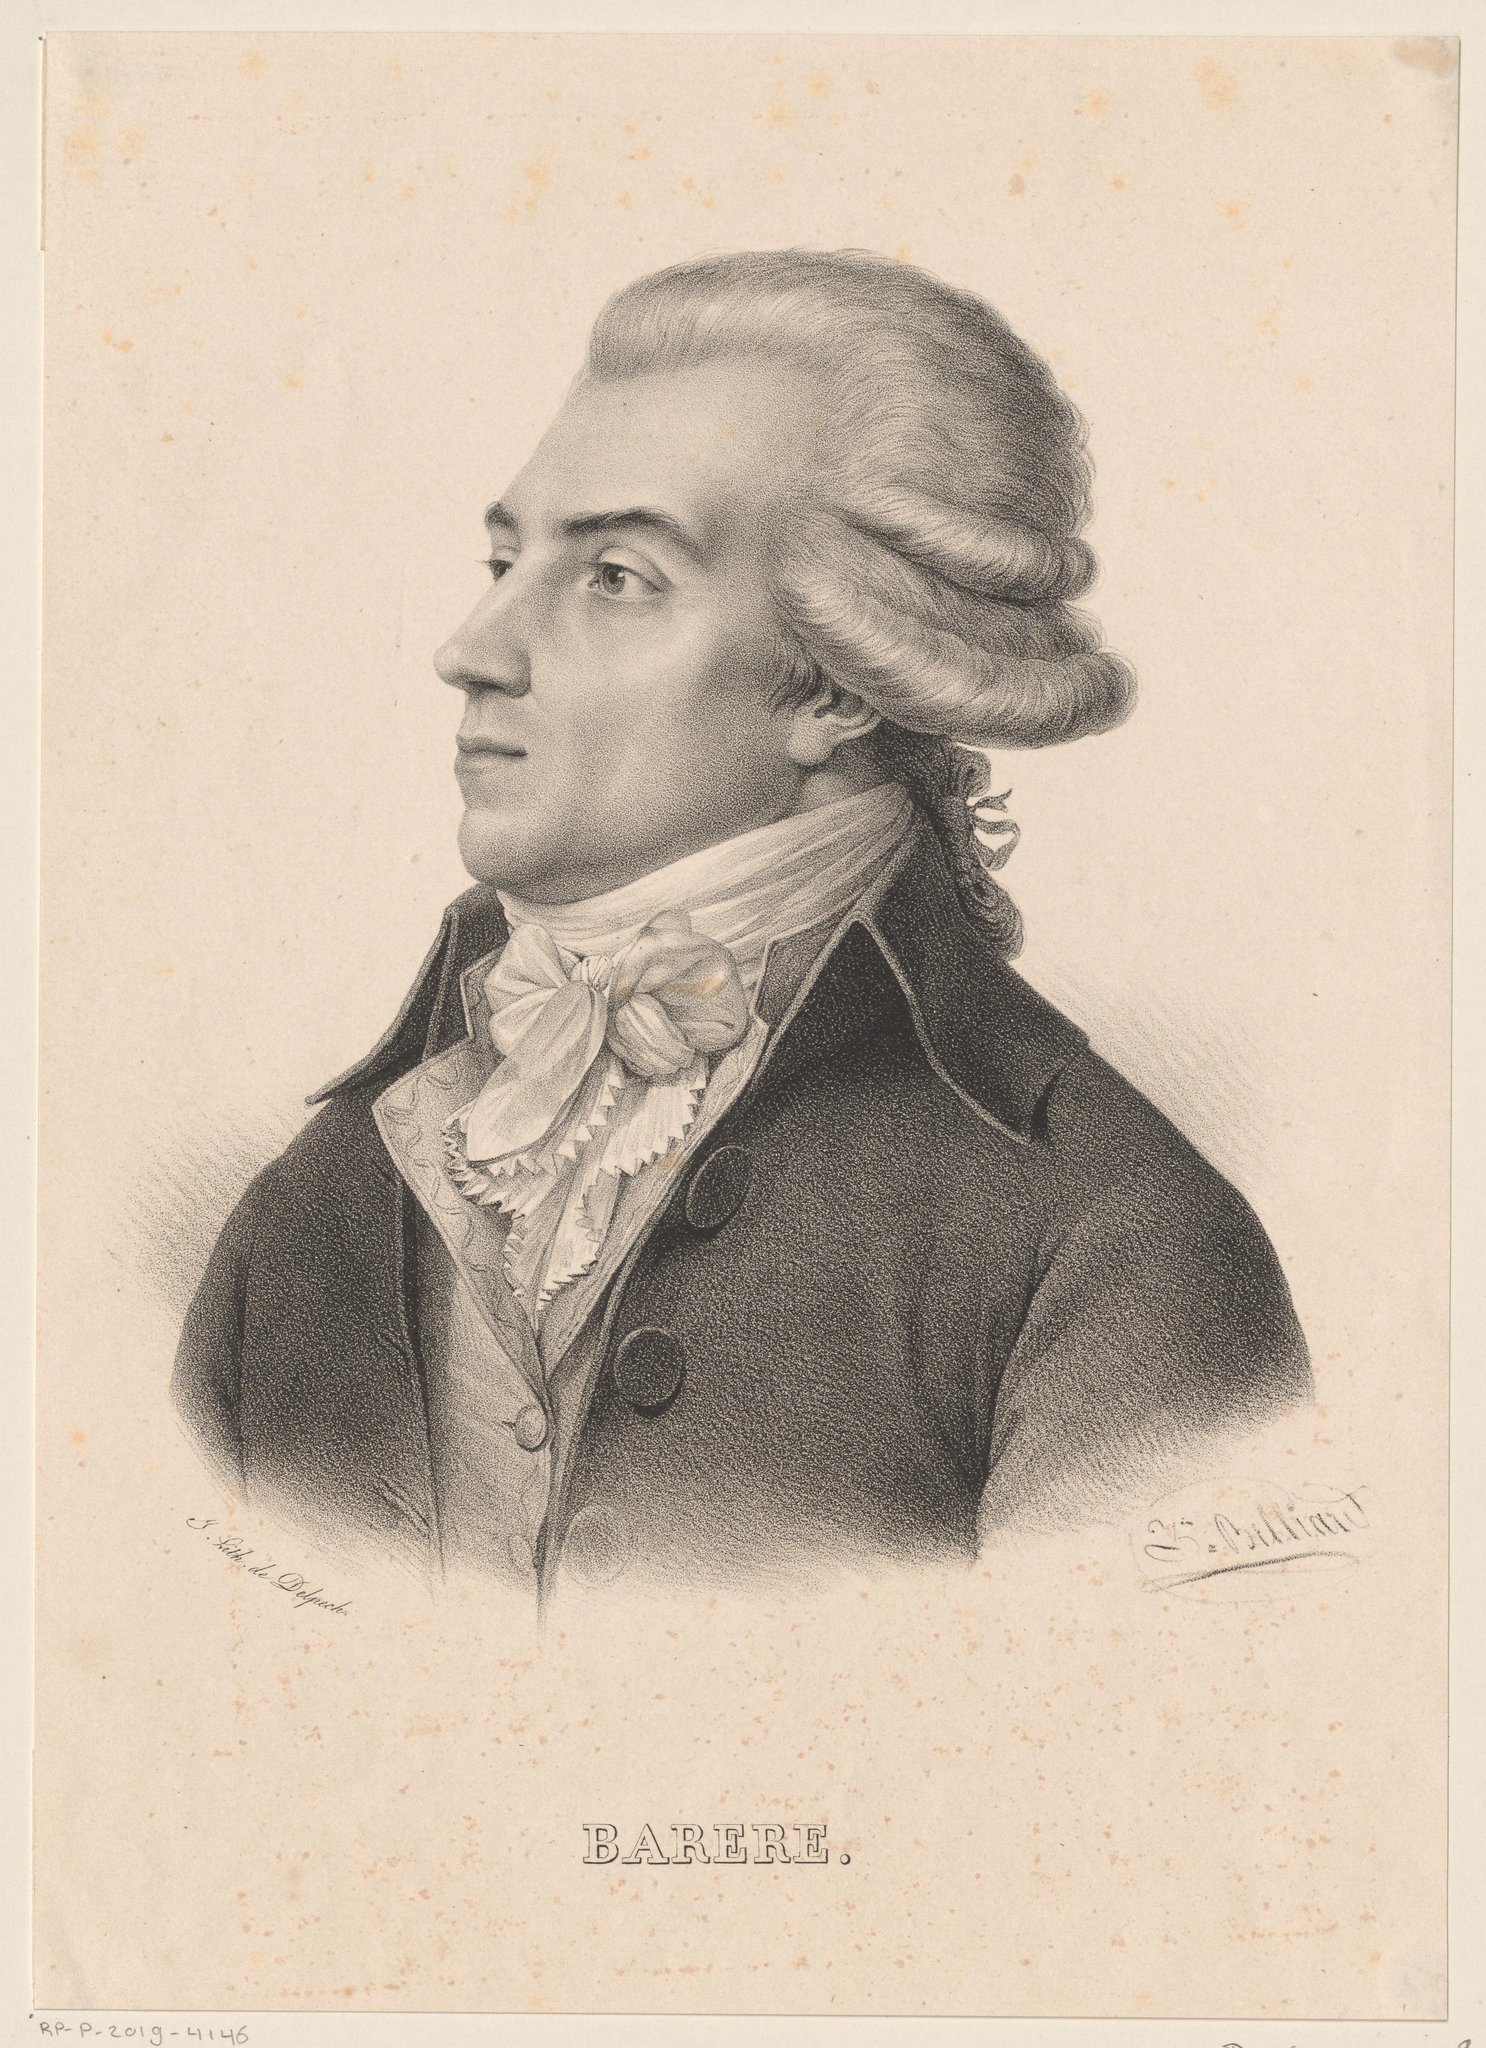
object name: print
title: Portret van Bertrand Barère de Vieuzac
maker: zéphirin félix jean marius belliard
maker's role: print maker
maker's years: 1798-1861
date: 1818-1842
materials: paper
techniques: lithograph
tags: politician, historical persons